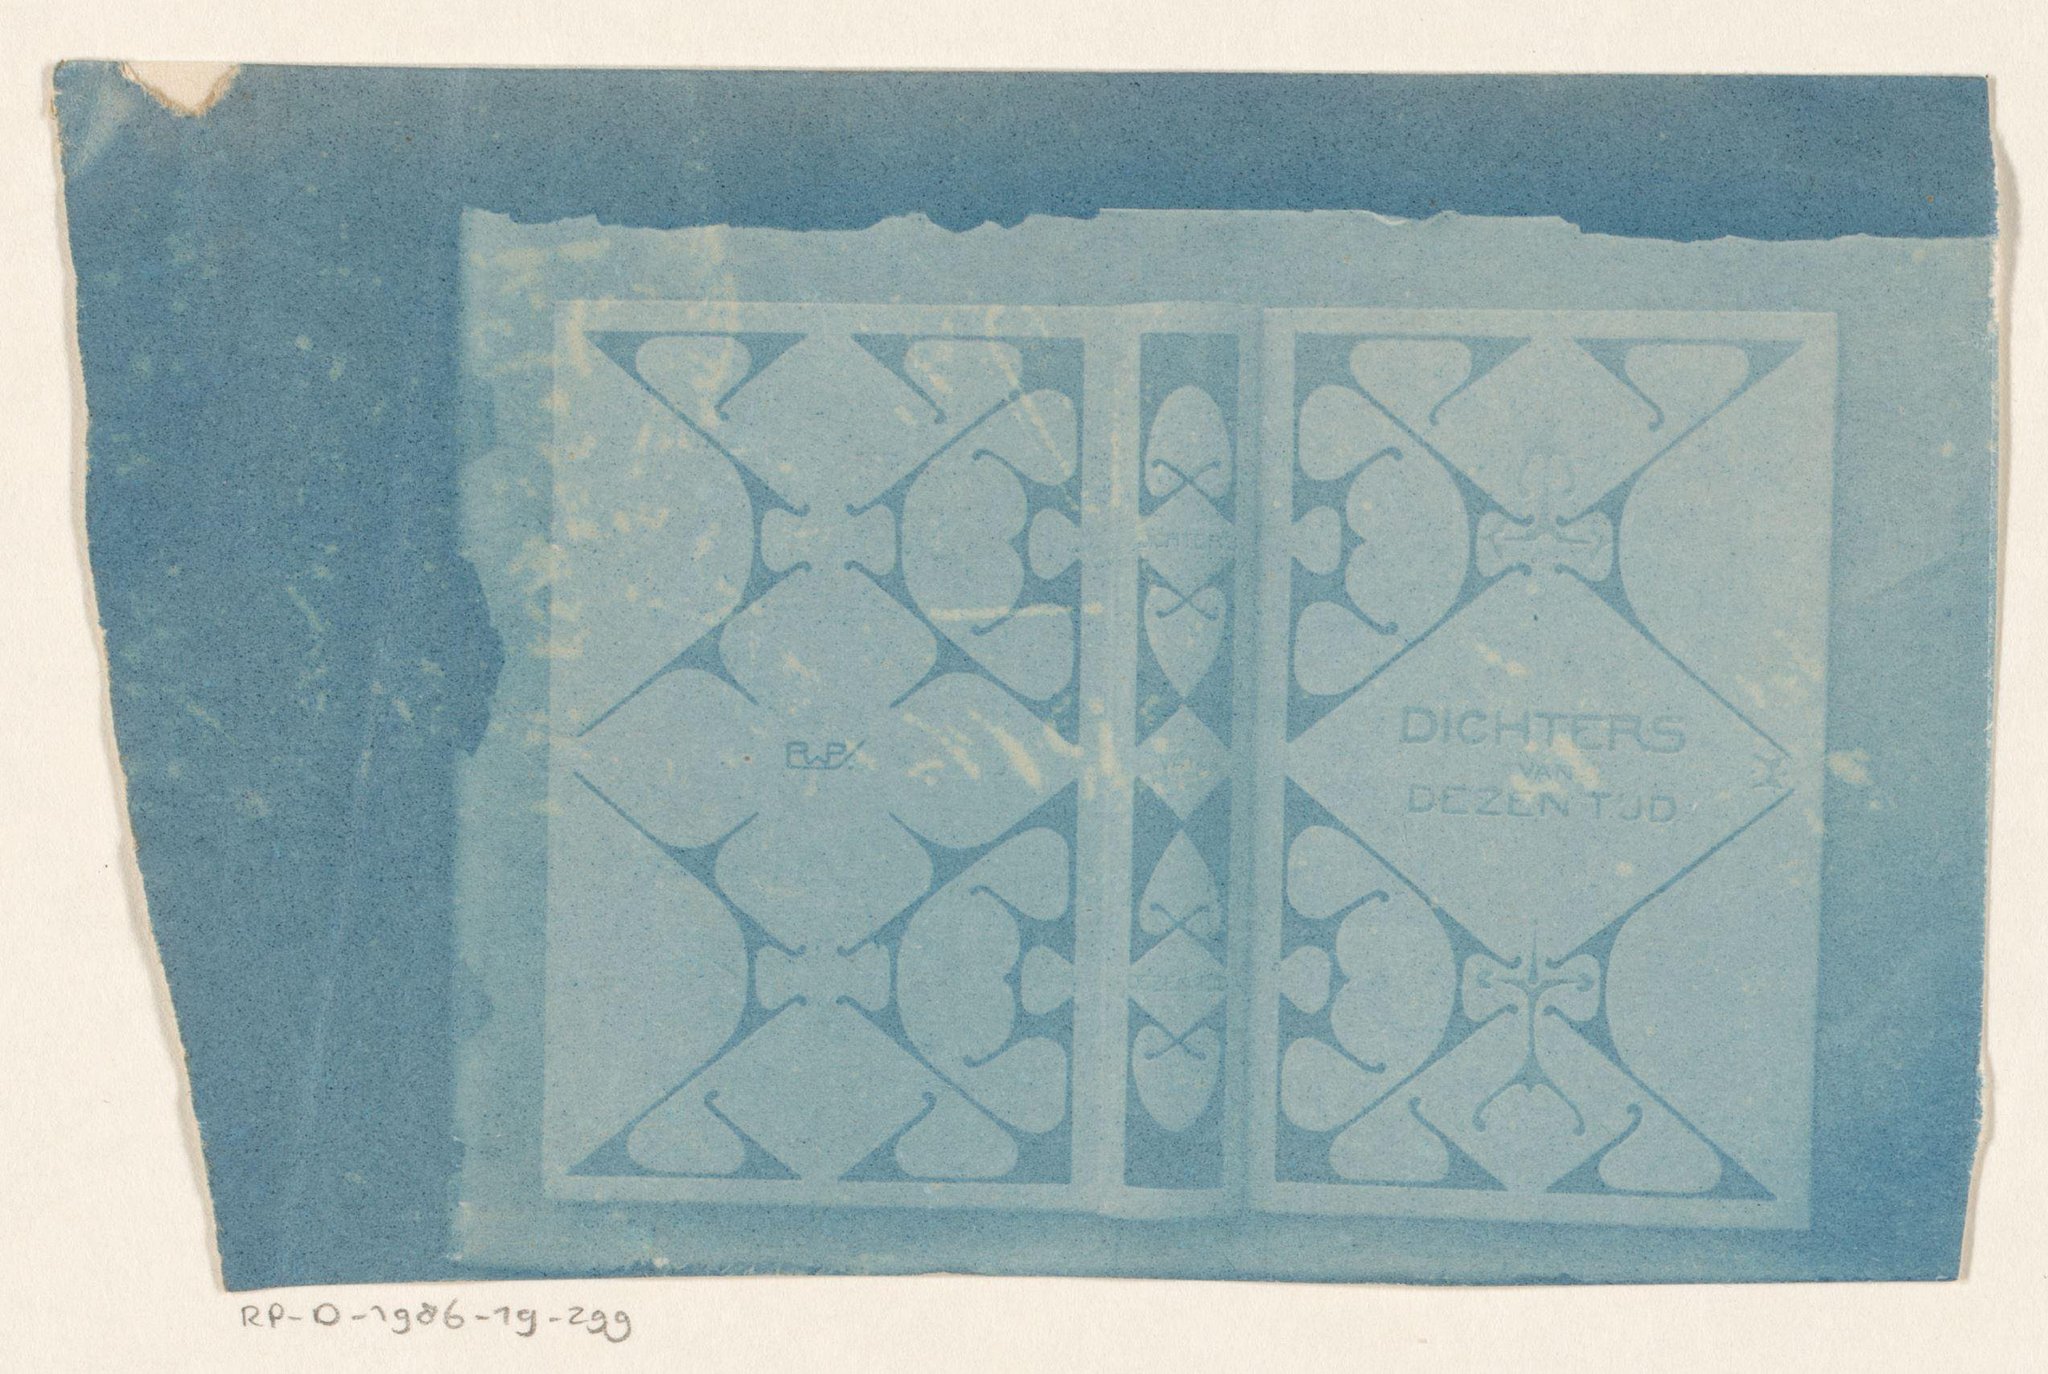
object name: photograph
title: Boekband van: Dichters van dezen tijd, 1899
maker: Anonymous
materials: photographic support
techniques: cyanotype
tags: book-cover, binding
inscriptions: collector's mark: ‘R:MVS.’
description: Hall, J.N. van. Dichters van dezen tijd. Amsterdam: Van Kampen, 1899. De reeks werd uitgegeven vanaf 1894 en verscheen vanaf 1899 (de derde druk) met een bandontwerp van R.W.P. de Vries Jr.